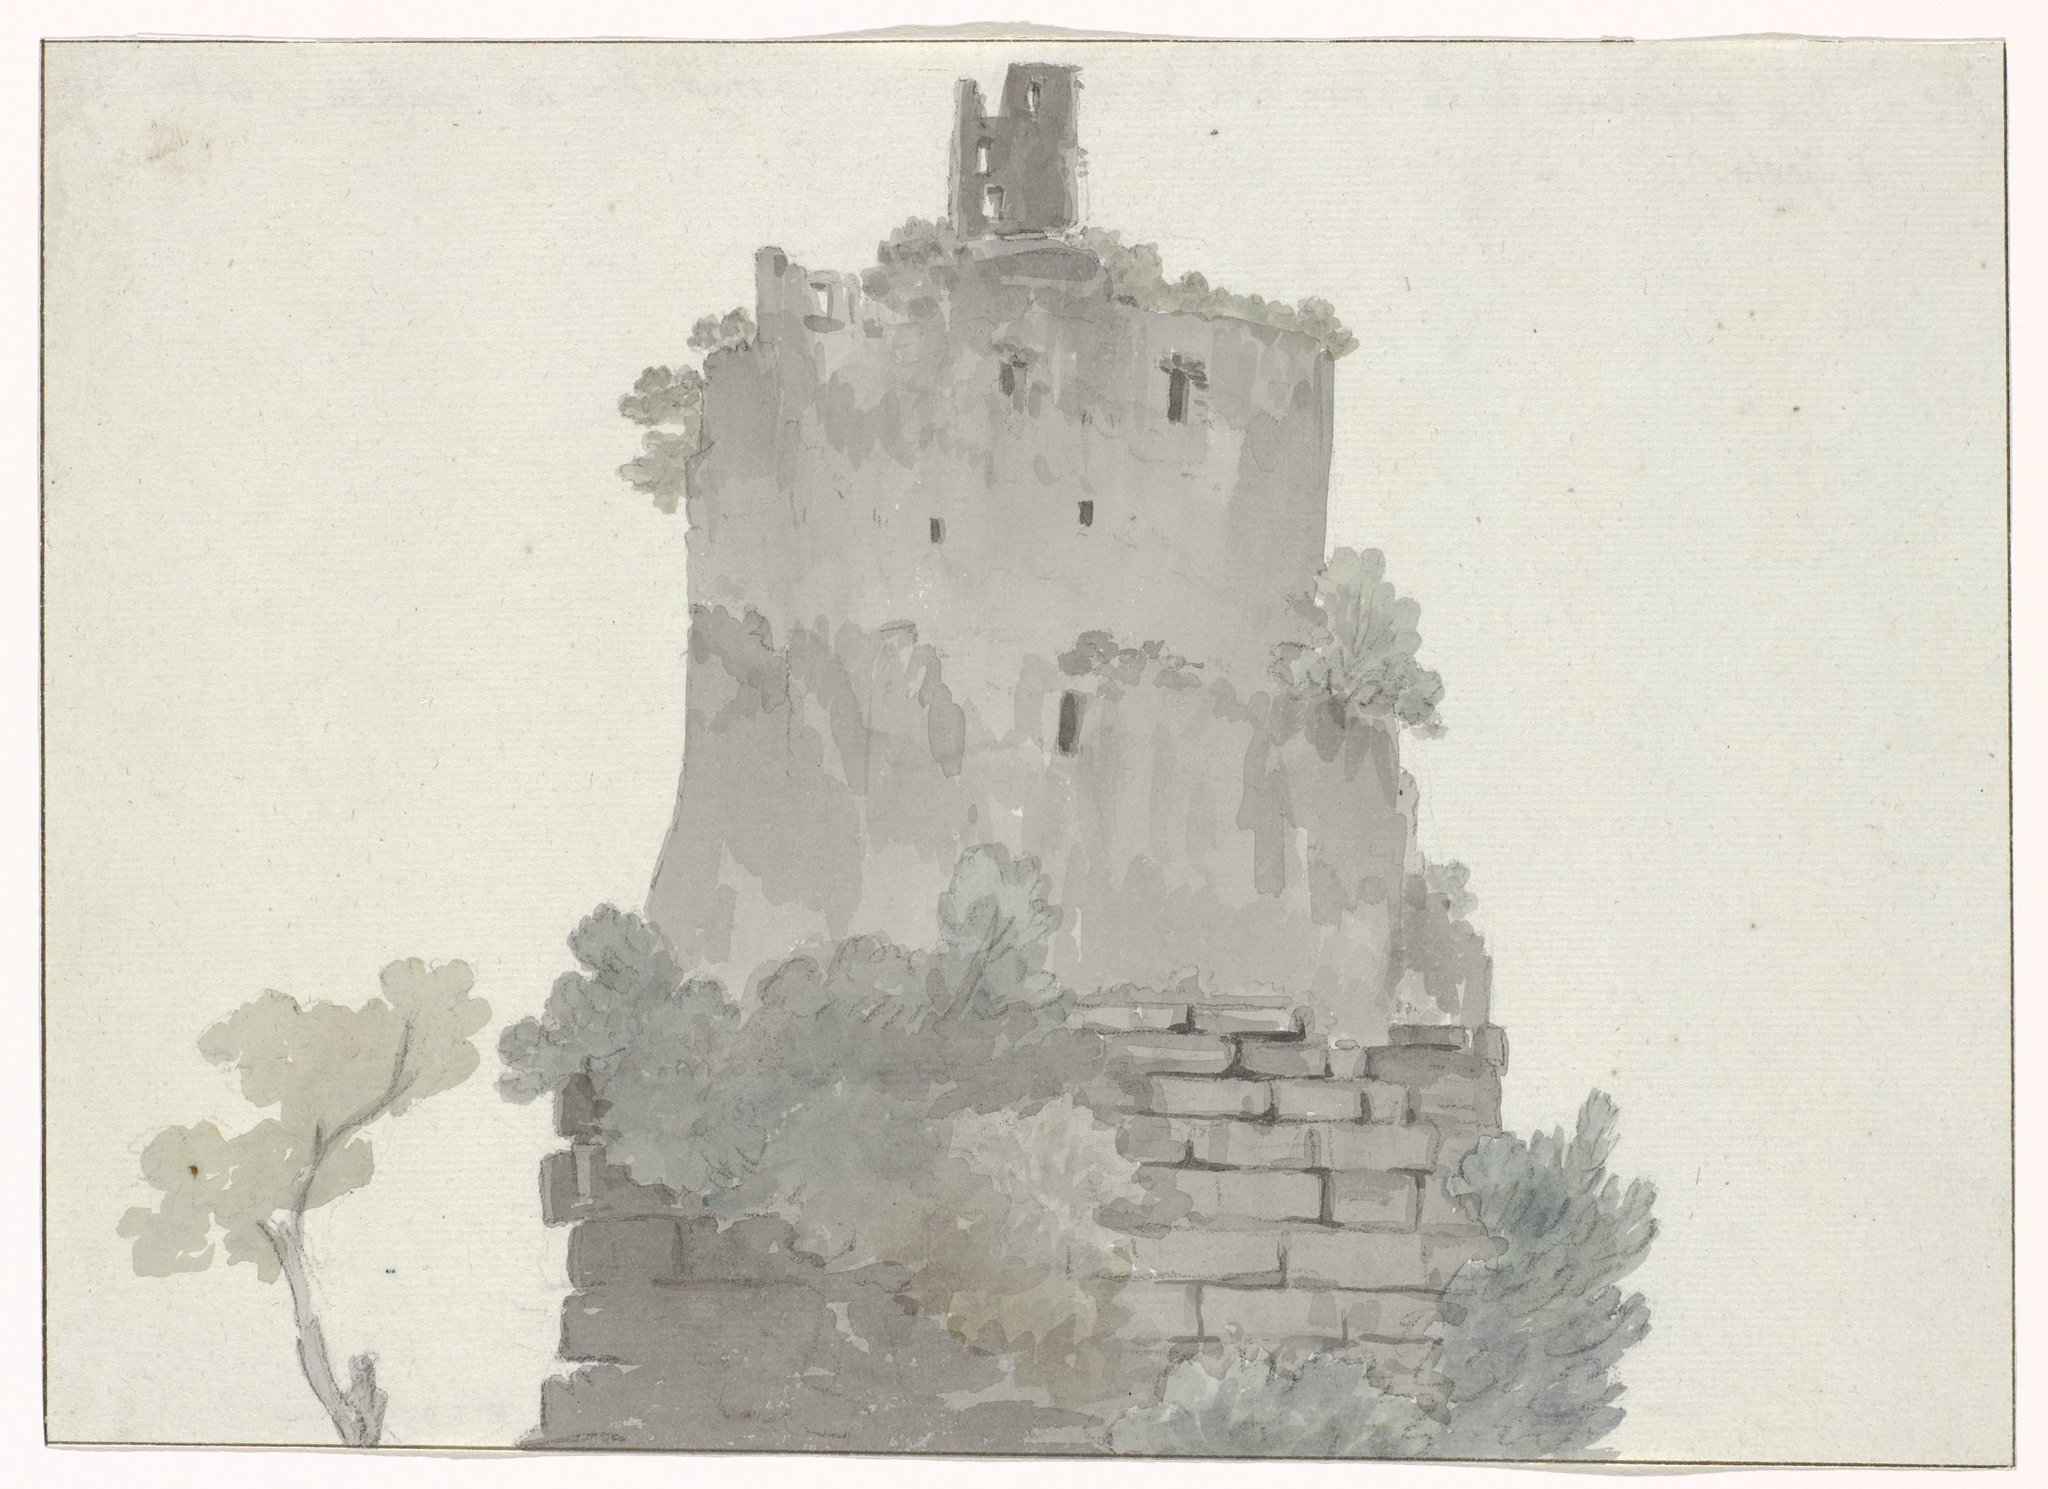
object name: watercolor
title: Exterieur van het graf van Ciceron tussen Itri en Gaeta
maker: louis ducros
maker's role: draughtsman, print maker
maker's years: 1748-1810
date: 1778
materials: chalk, paper, watercolor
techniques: brush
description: Tekening uit het album 'Voyage en Italie, en Sicile et à Malte', 1778.